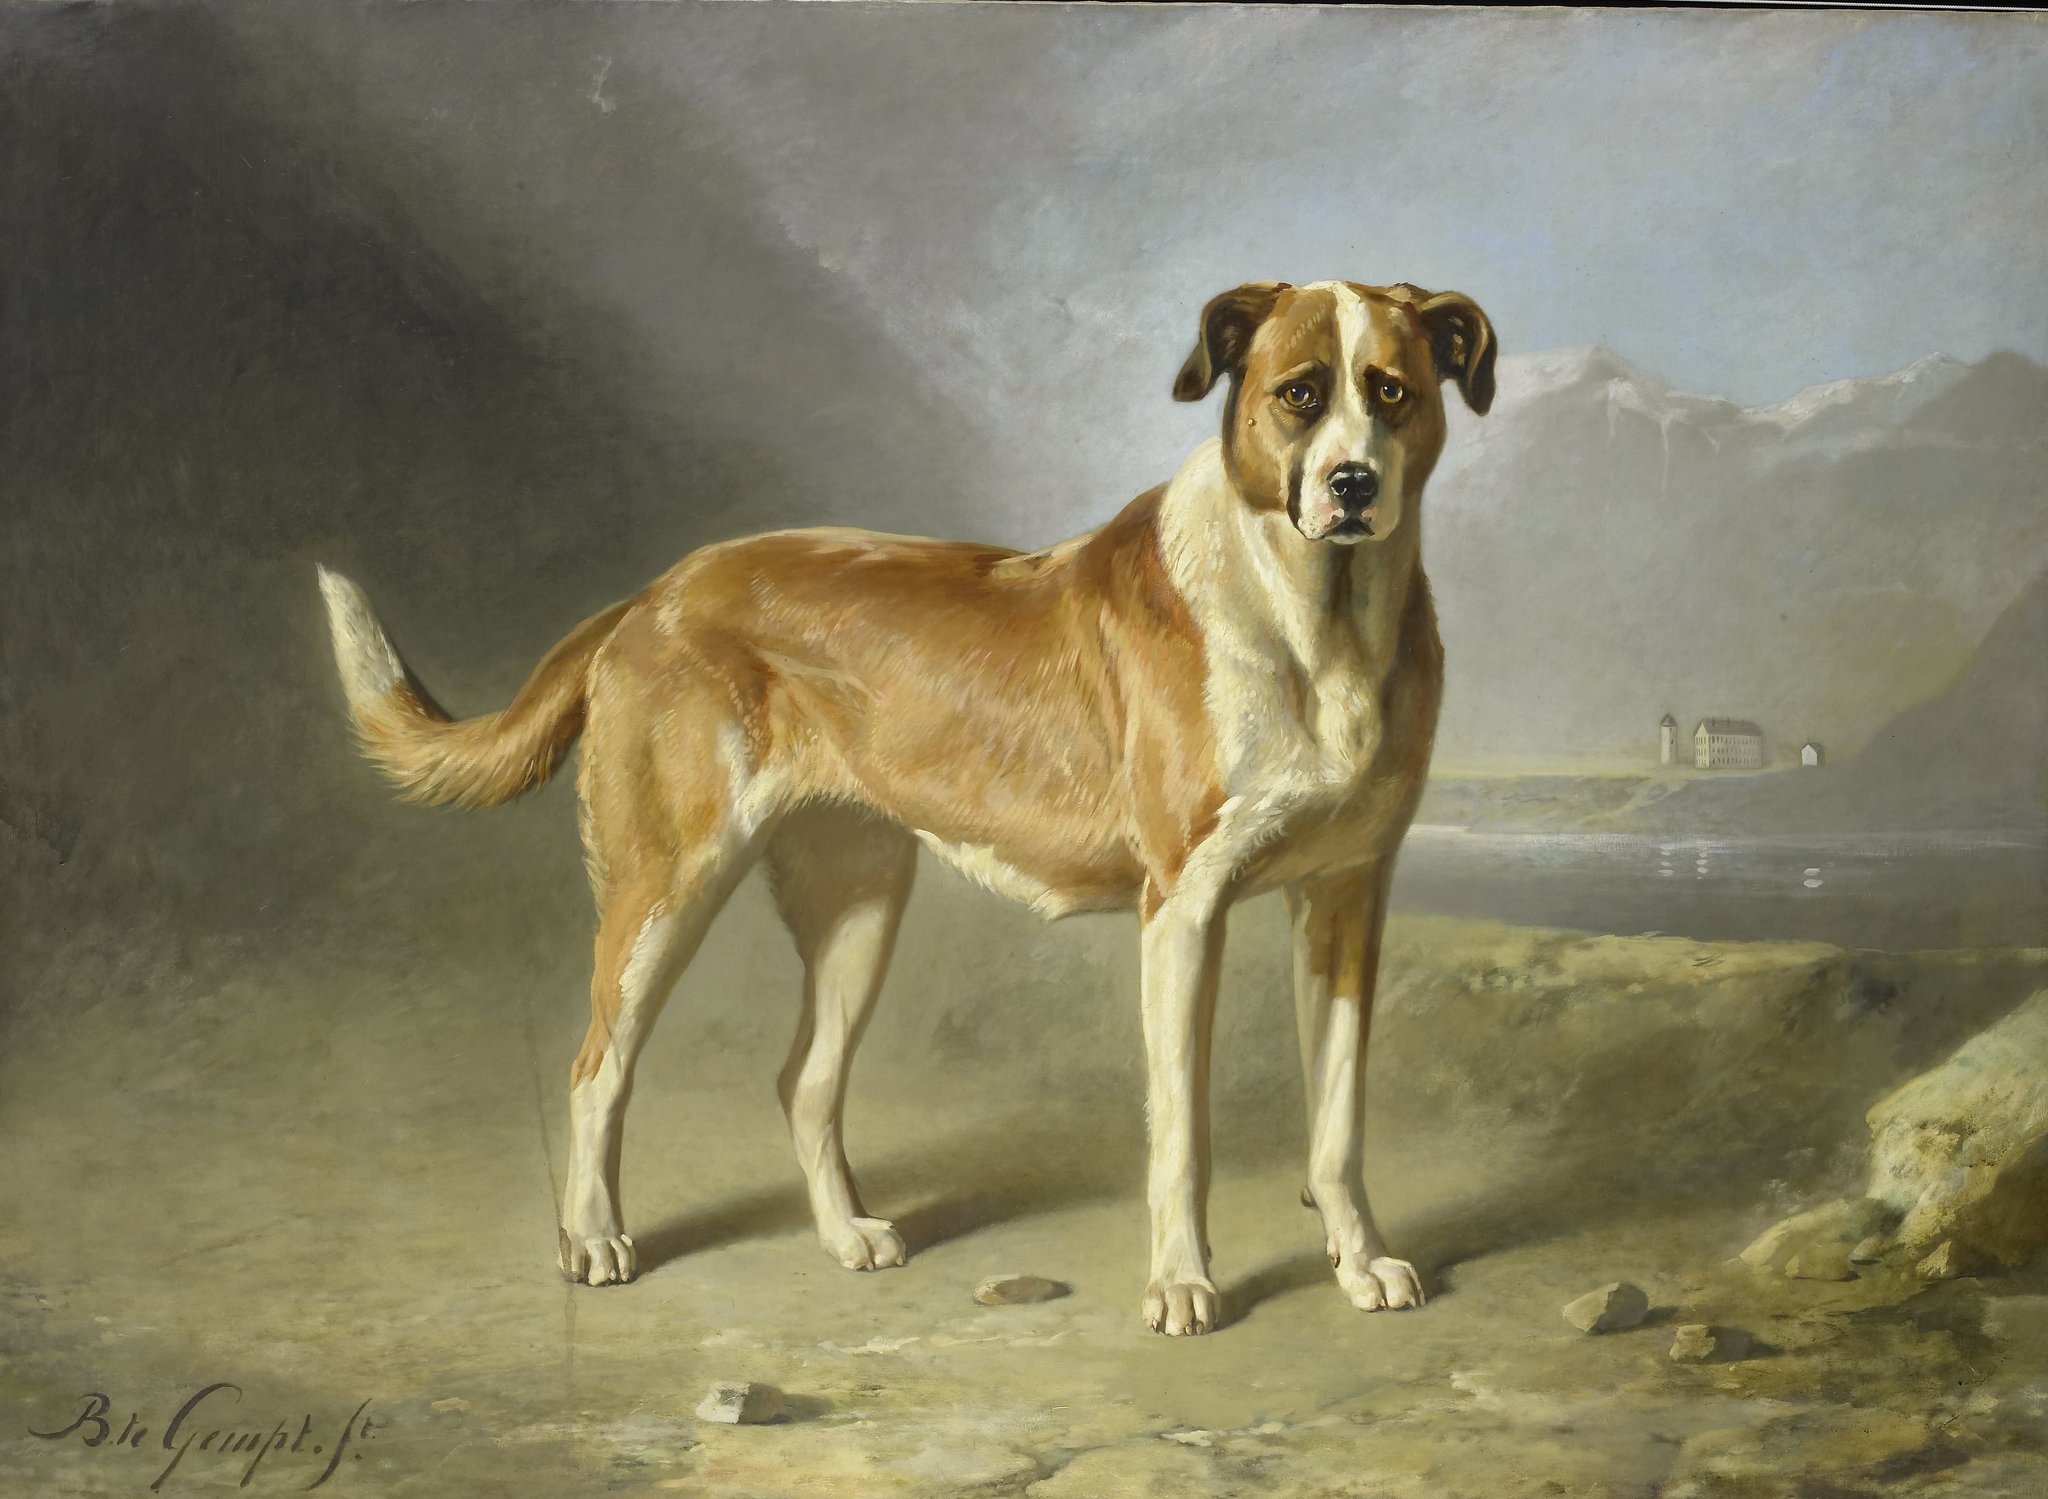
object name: painting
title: A St Bernard Dog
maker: bernard te gempt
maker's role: draughtsman, painter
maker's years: 1826-1879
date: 1850-1879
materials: canvas, oil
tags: dog (st.bernard)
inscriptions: signature: ‘B. te Gempt f.t’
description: Een sint-bernardshond, staand in een landschap, met in de verte bergen.